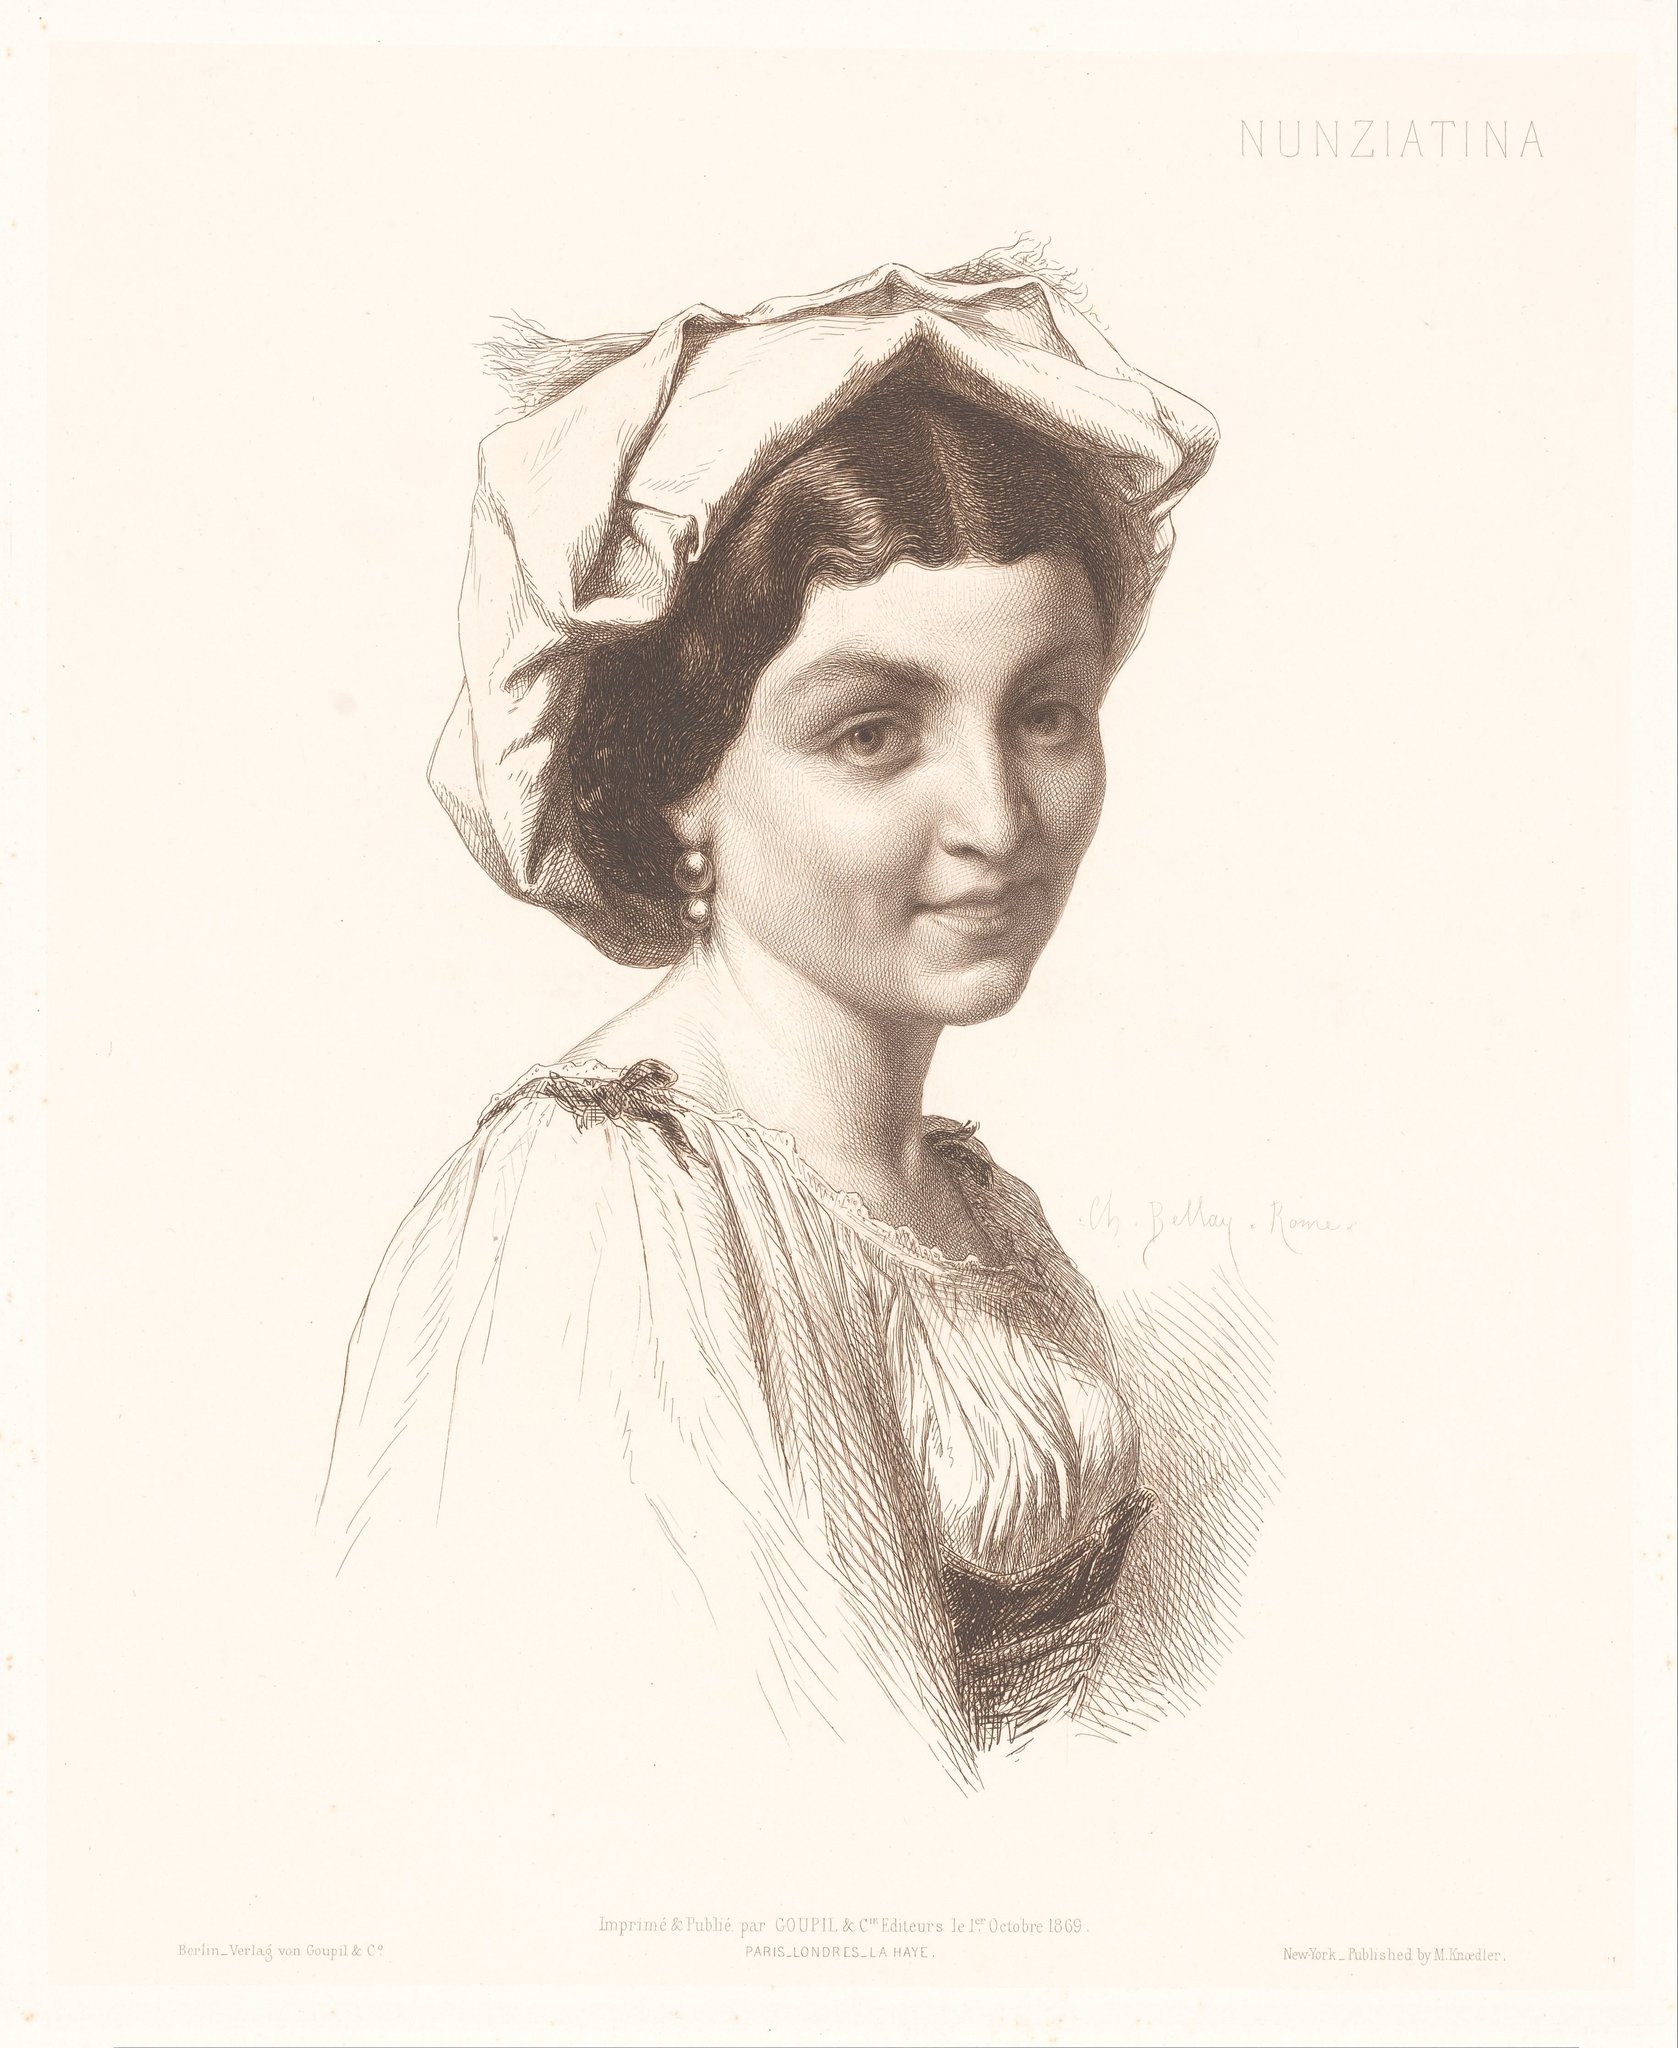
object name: print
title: Portret van een Italiaanse vrouw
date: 1869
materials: paper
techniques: etching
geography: paris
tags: historical persons, anonymous historical person portrayed - bb - woman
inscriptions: collector's mark: Lugt 2228